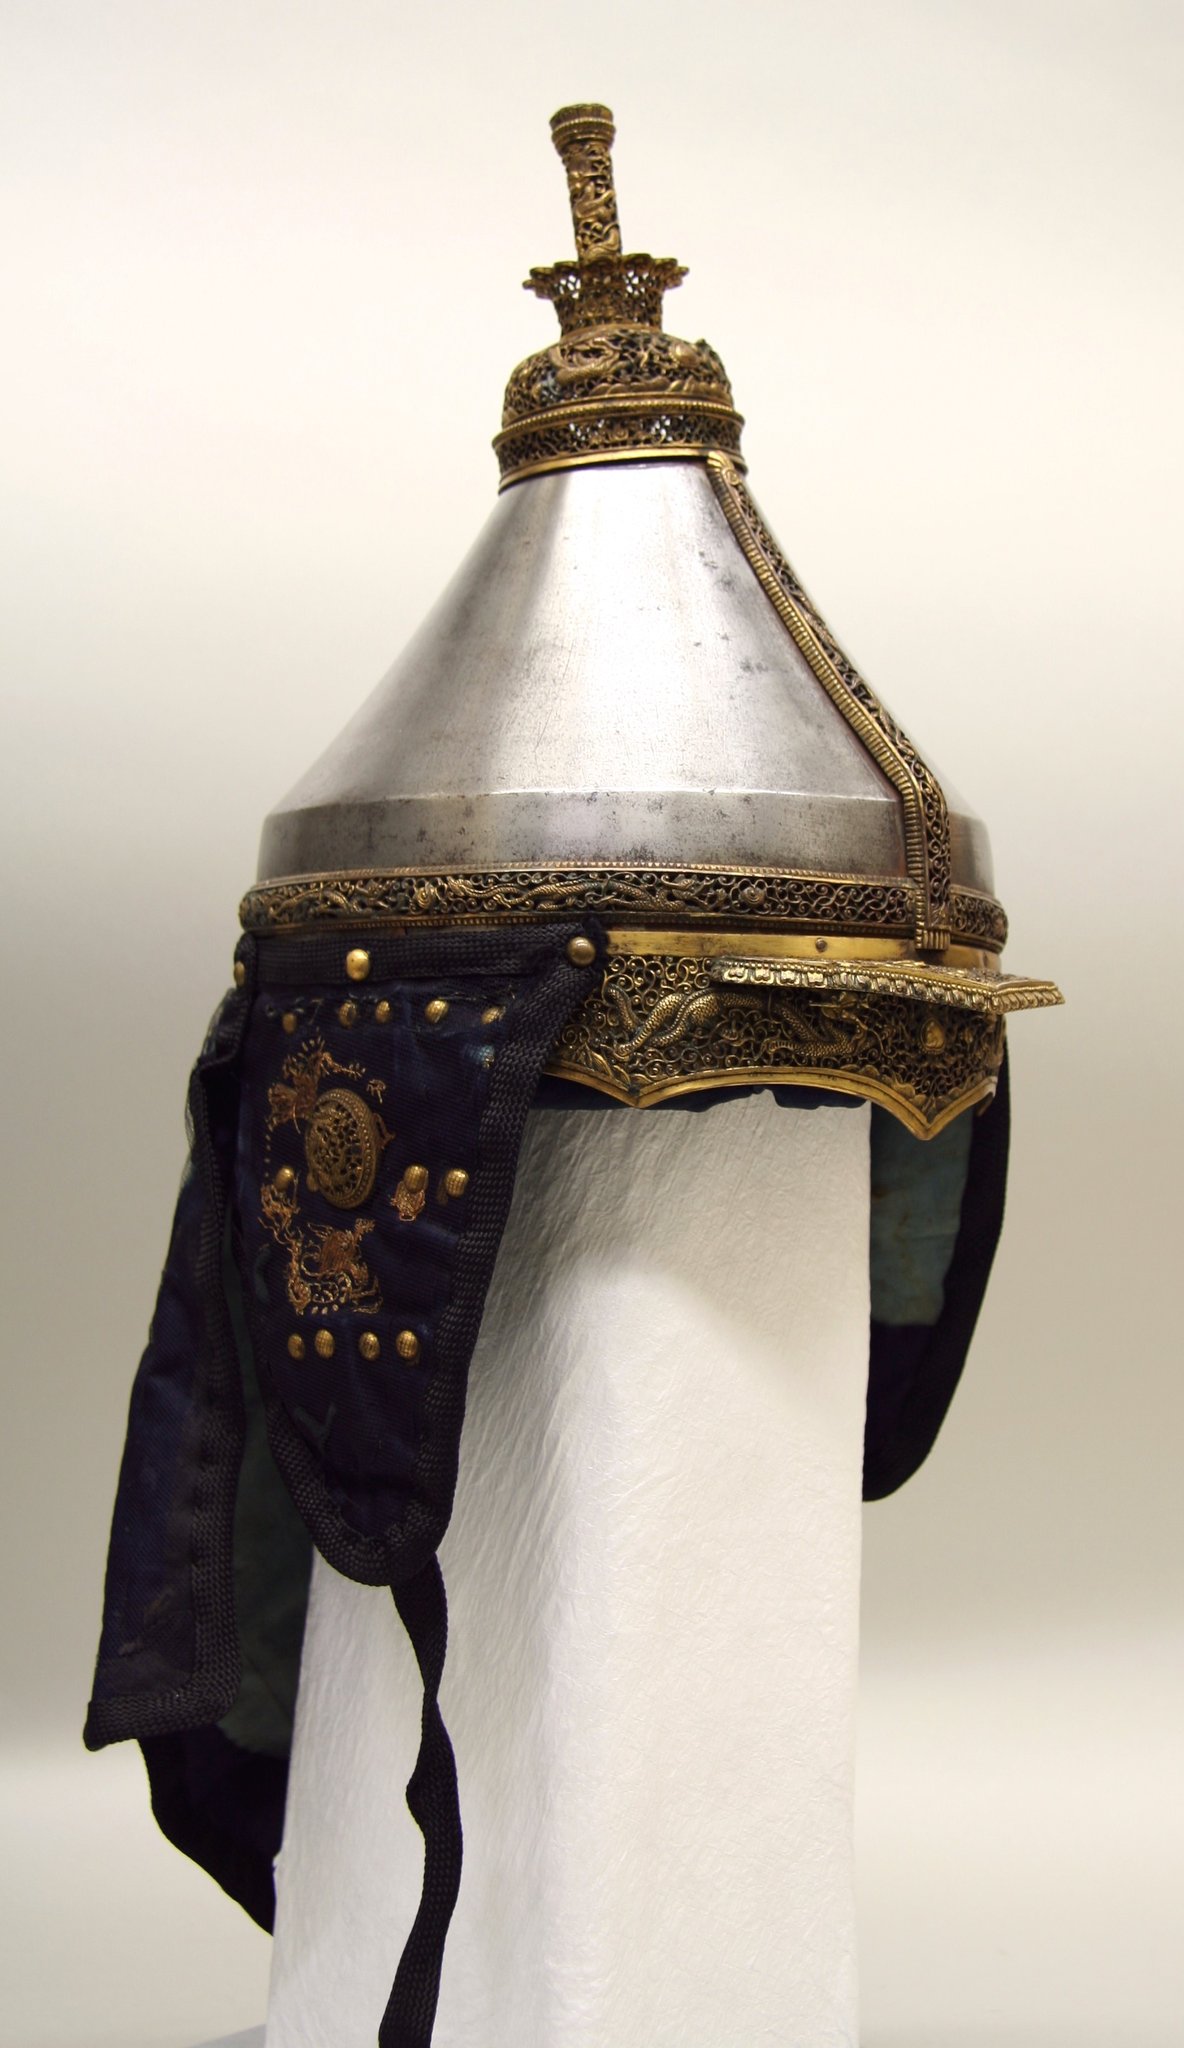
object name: armor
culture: chinese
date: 1701-1800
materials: copper alloy, metal thread, steel, textile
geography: china